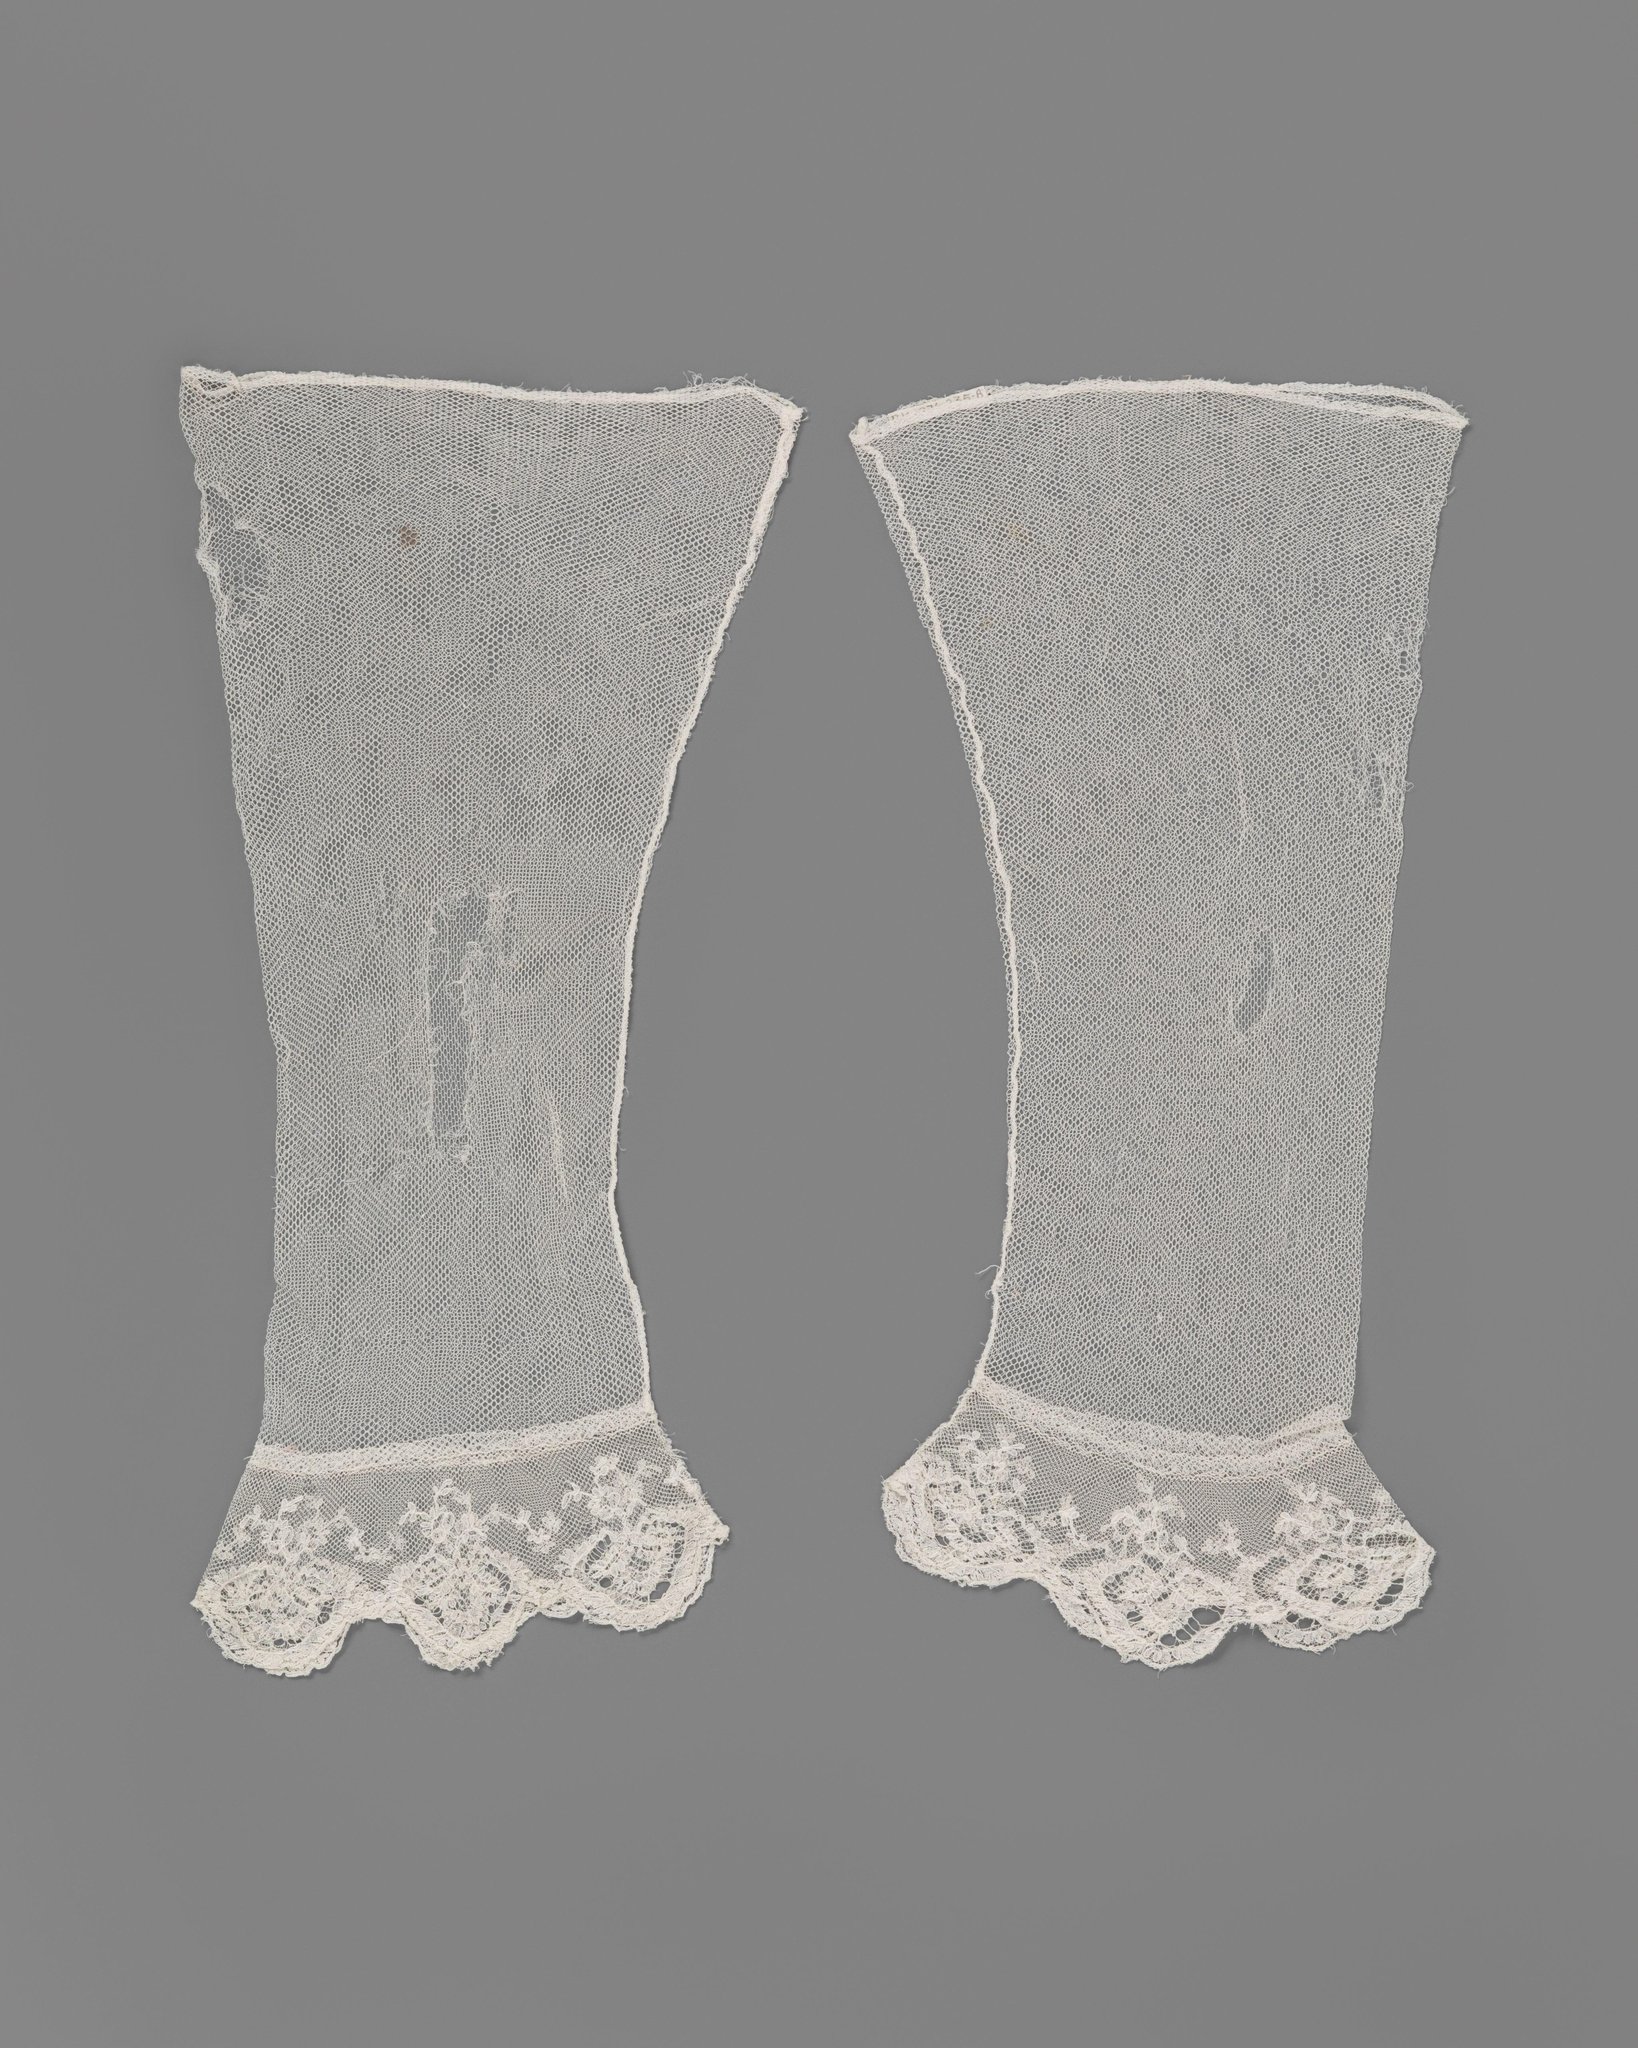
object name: undersleeve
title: Ondermouw van tule met kanten boord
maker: Anonymous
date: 1935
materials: lace, fiber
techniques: lace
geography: western europe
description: Ondermouw van tule en kant. Glad model mouw waaraan aangezet een afhangende machinale geschulpte strook kant, versierd met bloemen.